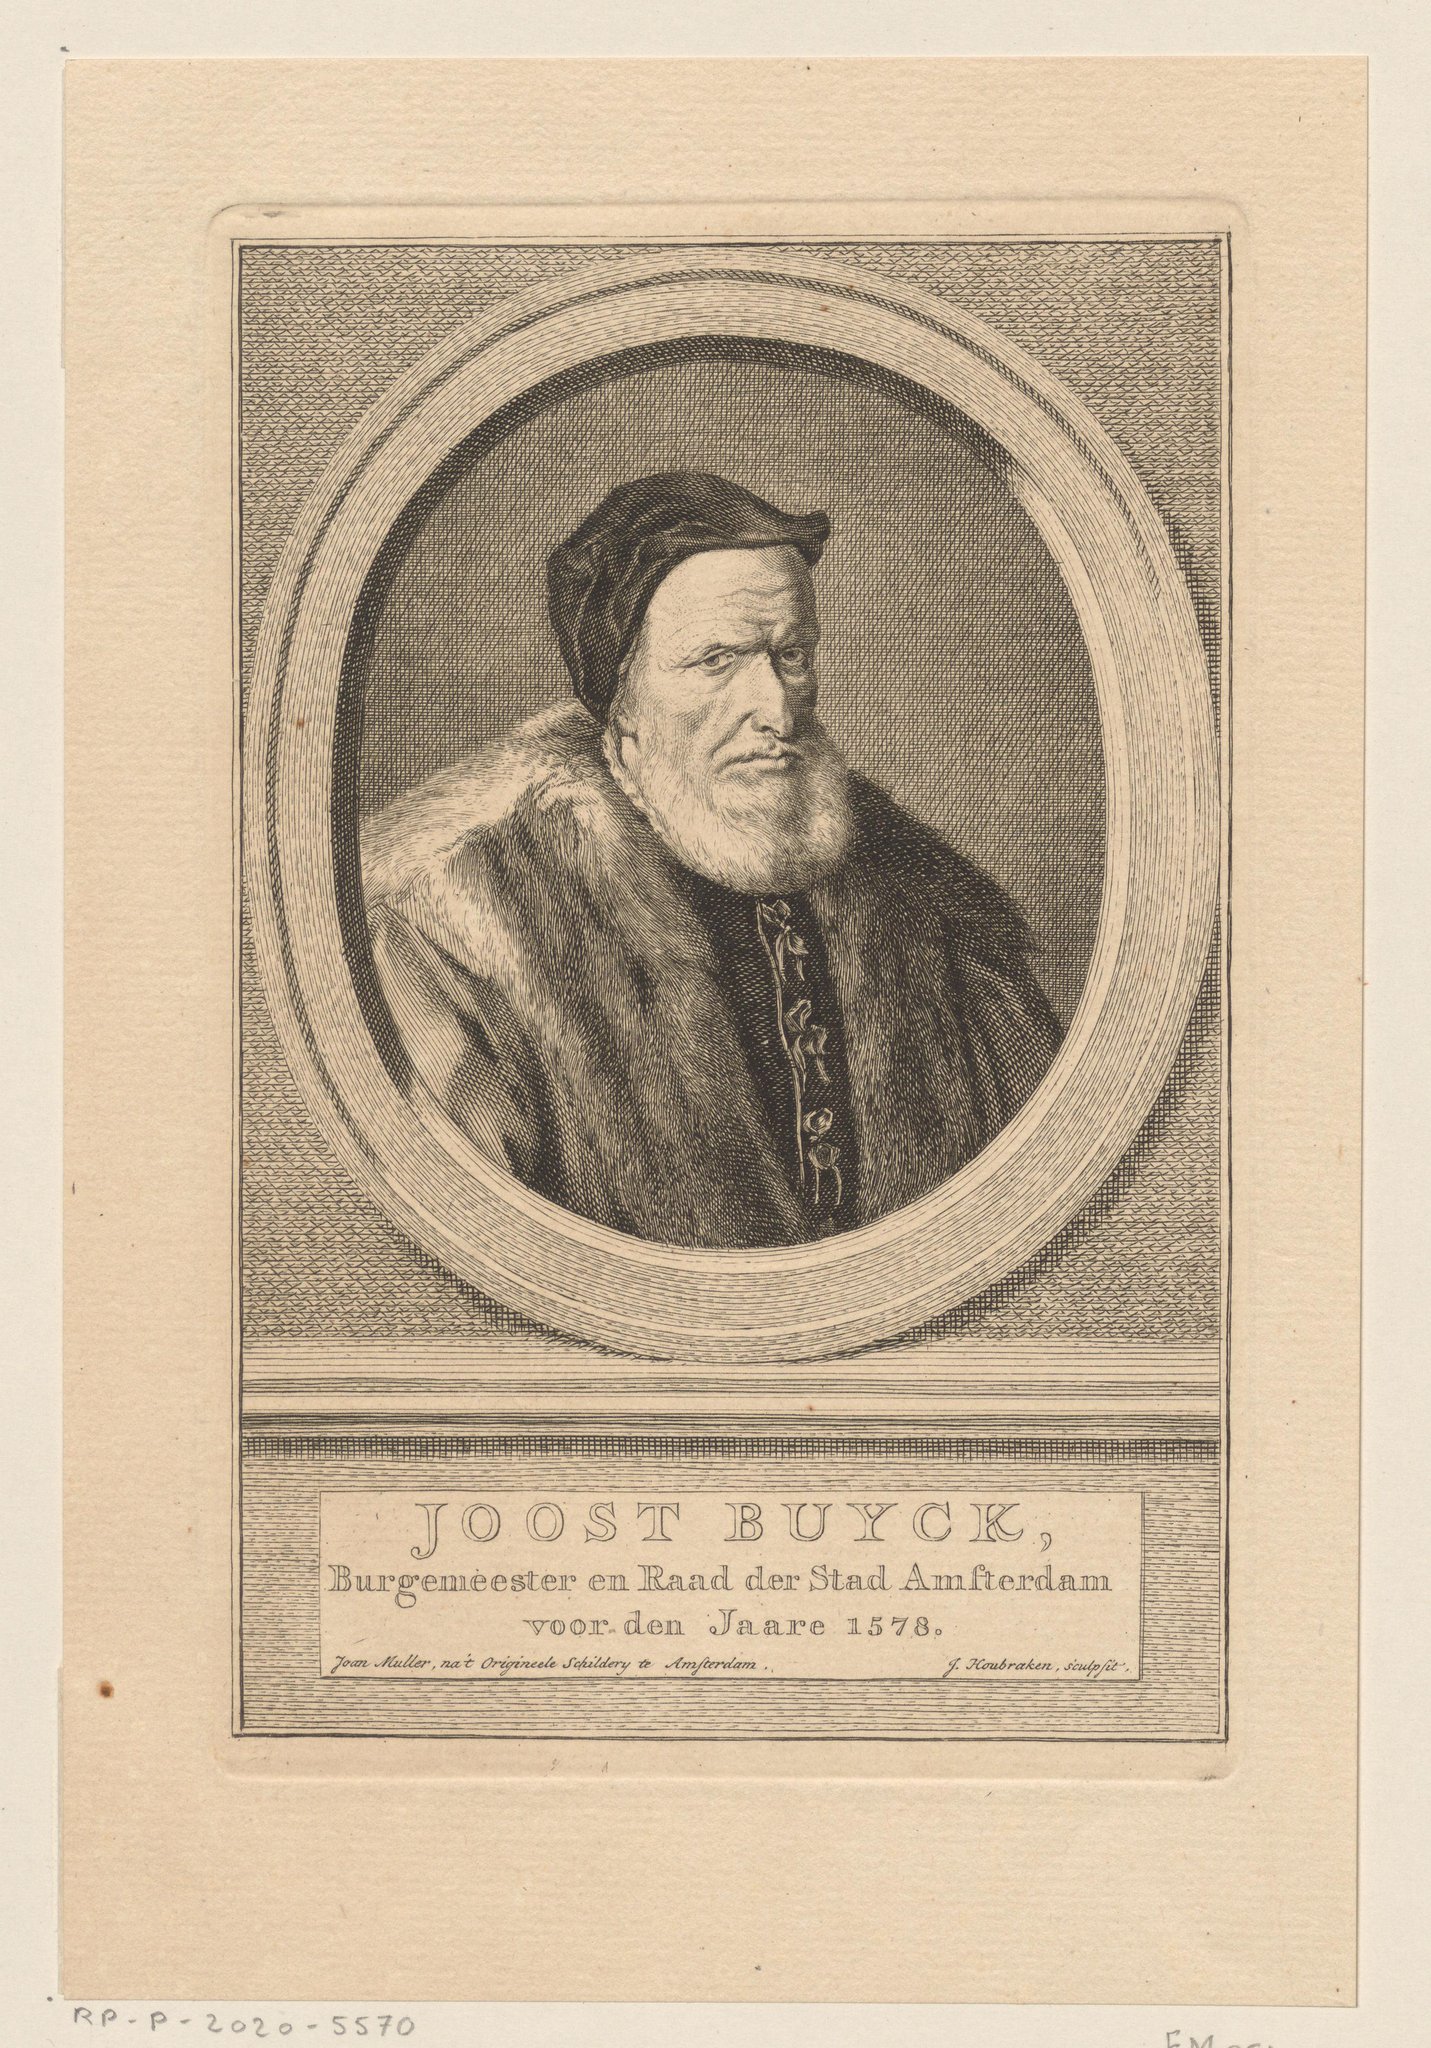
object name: print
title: Portret van Joost Sijbrandtsz. Buyck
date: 1749-1759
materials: paper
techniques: engraving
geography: amsterdam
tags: amsterdam, leiden, mayor, mayor, burgomaster, historical persons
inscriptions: collector's mark: Lugt 2228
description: Prent oorspronkelijk bedoeld als aanvulling op: Wagenaar, Jan. Vaderlandsche historie, vervattende de geschiedenissen der Vereenigde Nederlanden (…). 21 dln. Amsterdam: Isaak Tirion, 1749-1759 (eerste editie). De portretten werden echter pas toegevoegd bij de 1796-editie door Johannes Allart: Wagenaar, Jan. Vaderlandsche historie, vervattende de geschiedenissen der nu Vereenigde Nederlanden (…). 21 dln. Amsterdam: Johannes Allart, 1790-1796.